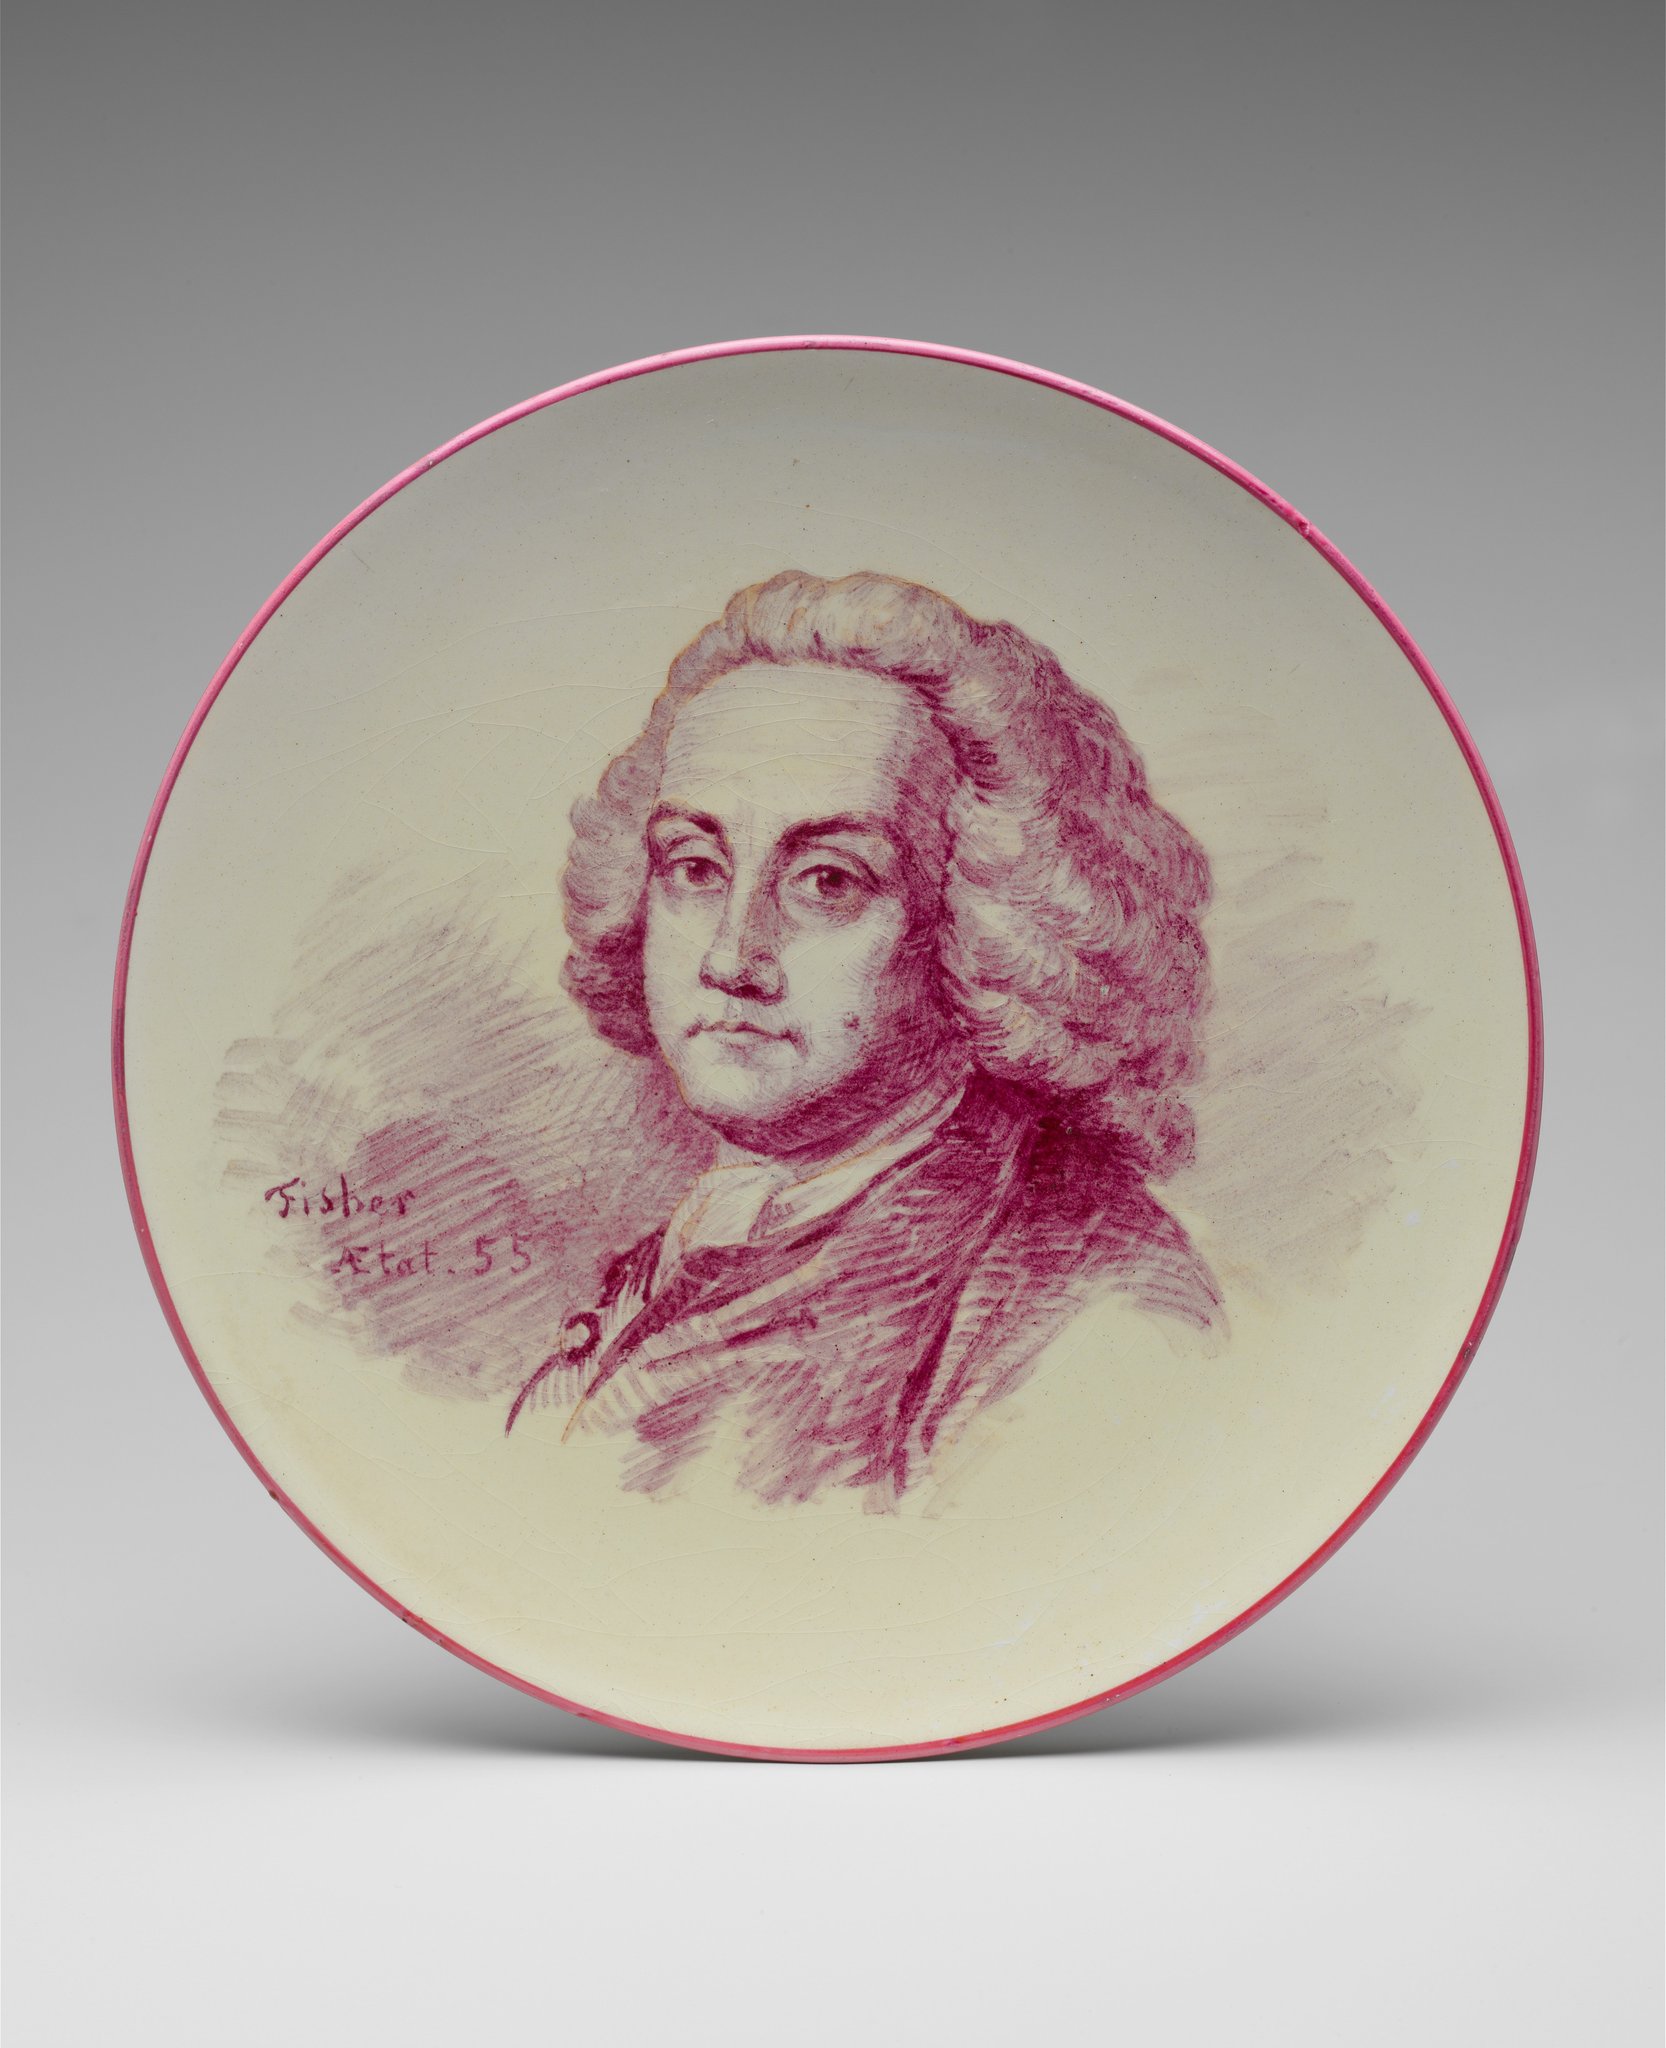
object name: plate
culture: french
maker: emile dupont-zipcy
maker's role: designer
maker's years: 1822-1885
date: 1776-1883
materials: faience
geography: france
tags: men,portraits